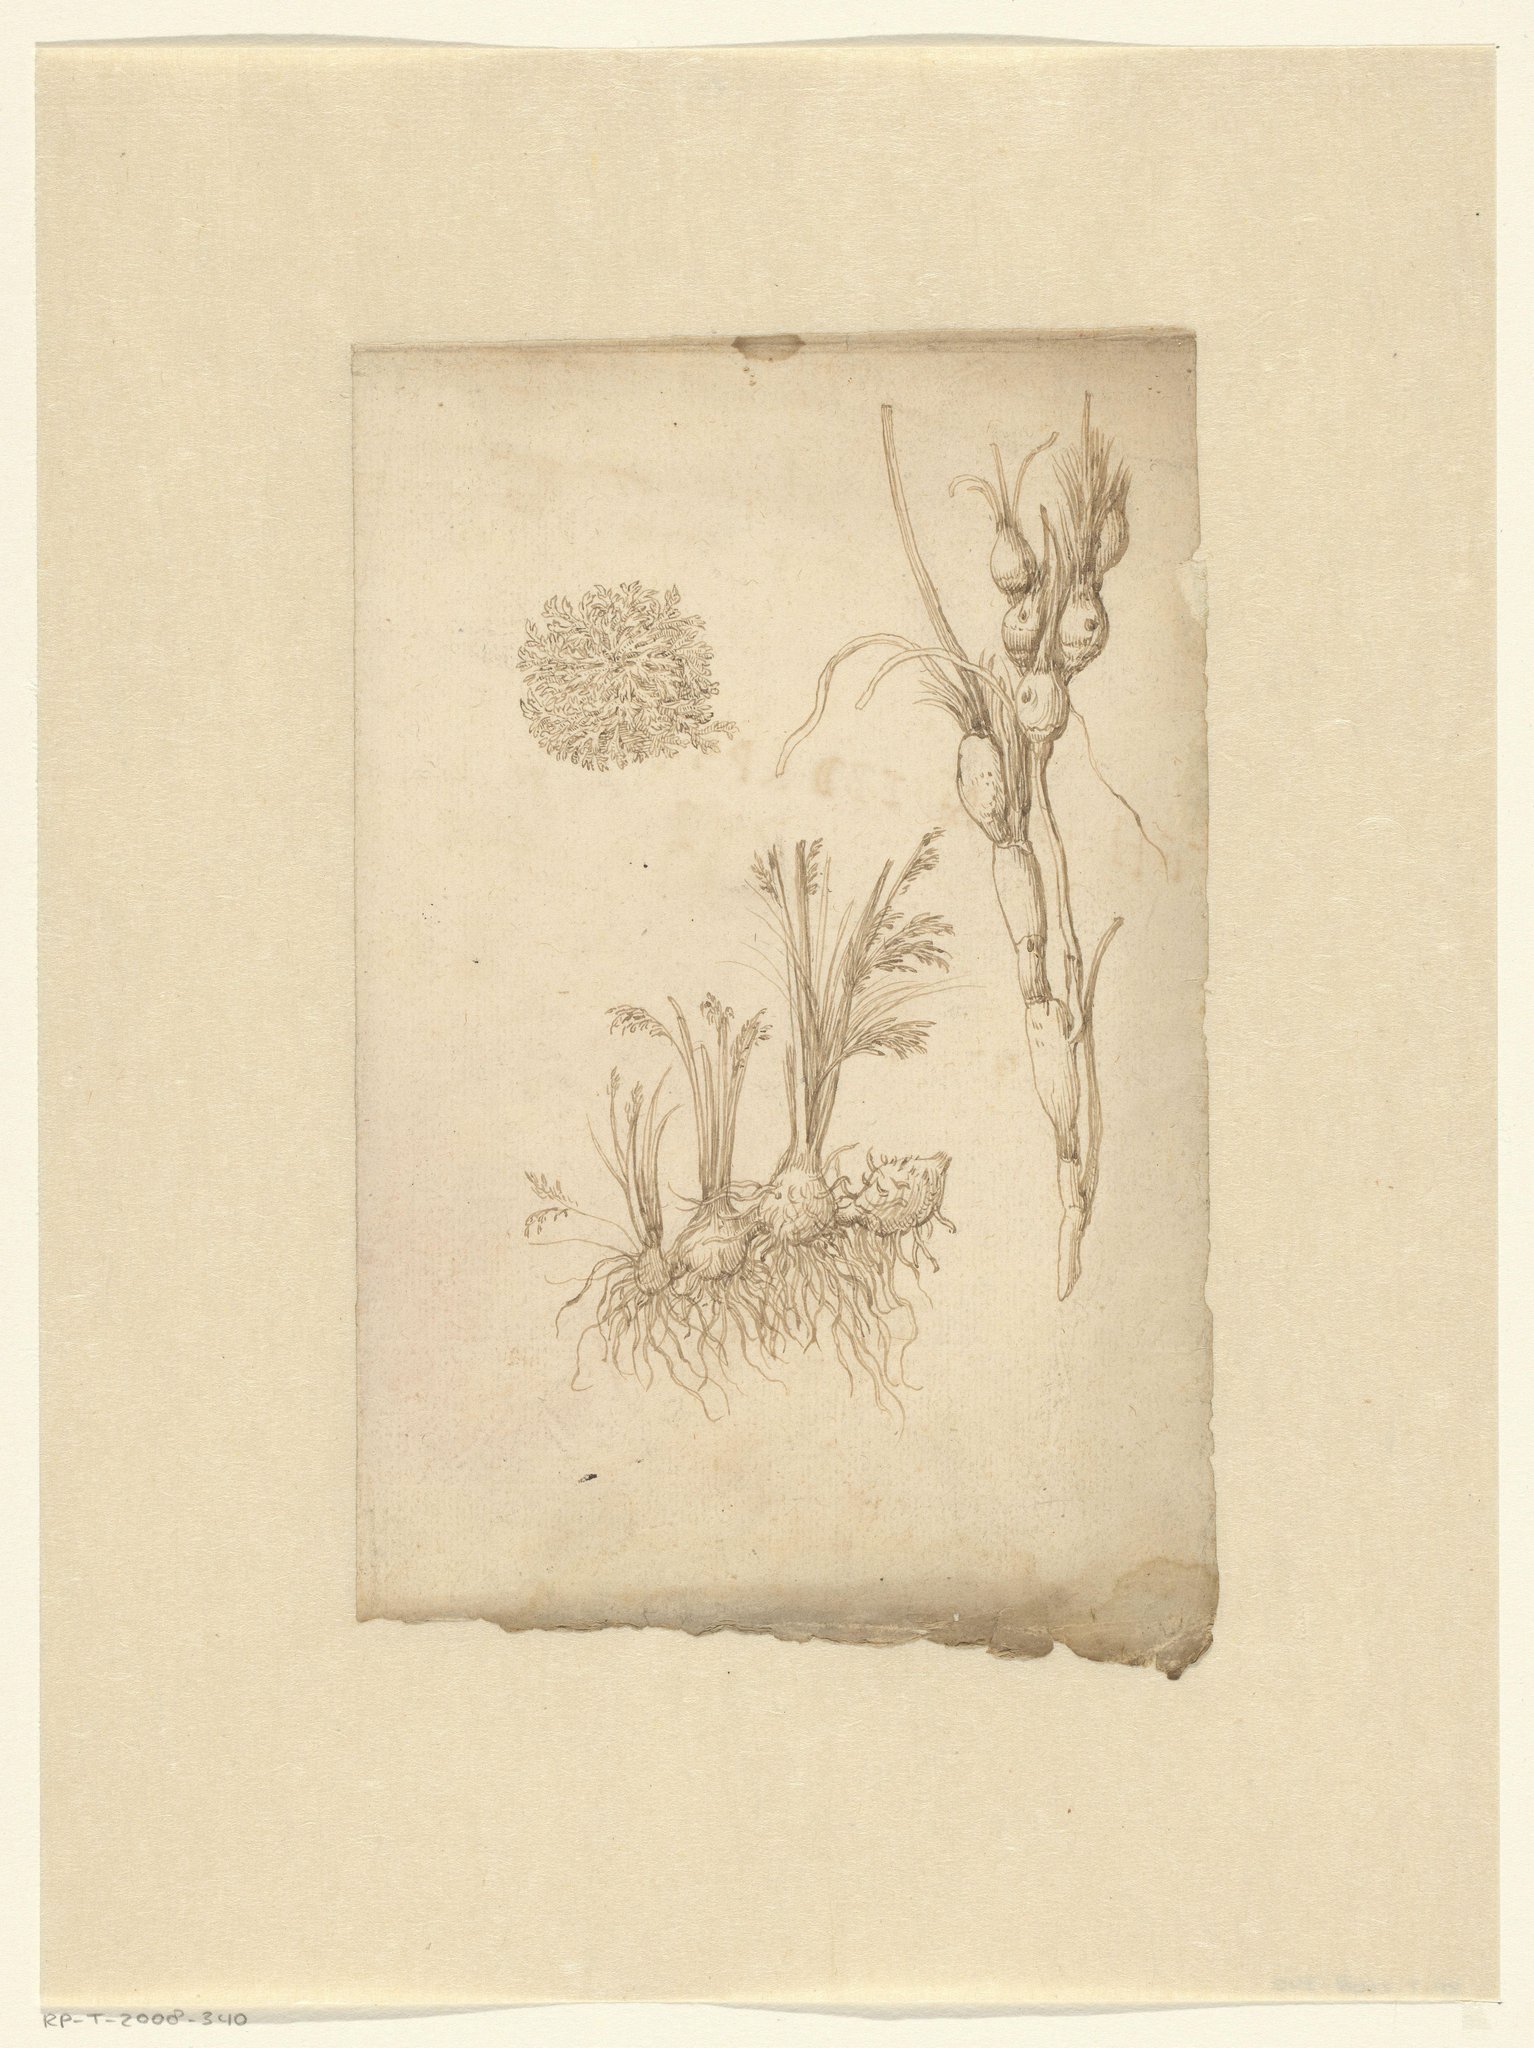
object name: drawing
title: Groen zeemos met smalle bladeren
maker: Anonymous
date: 1575-1599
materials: ink, paper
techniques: pen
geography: netherlands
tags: plants; vegetation